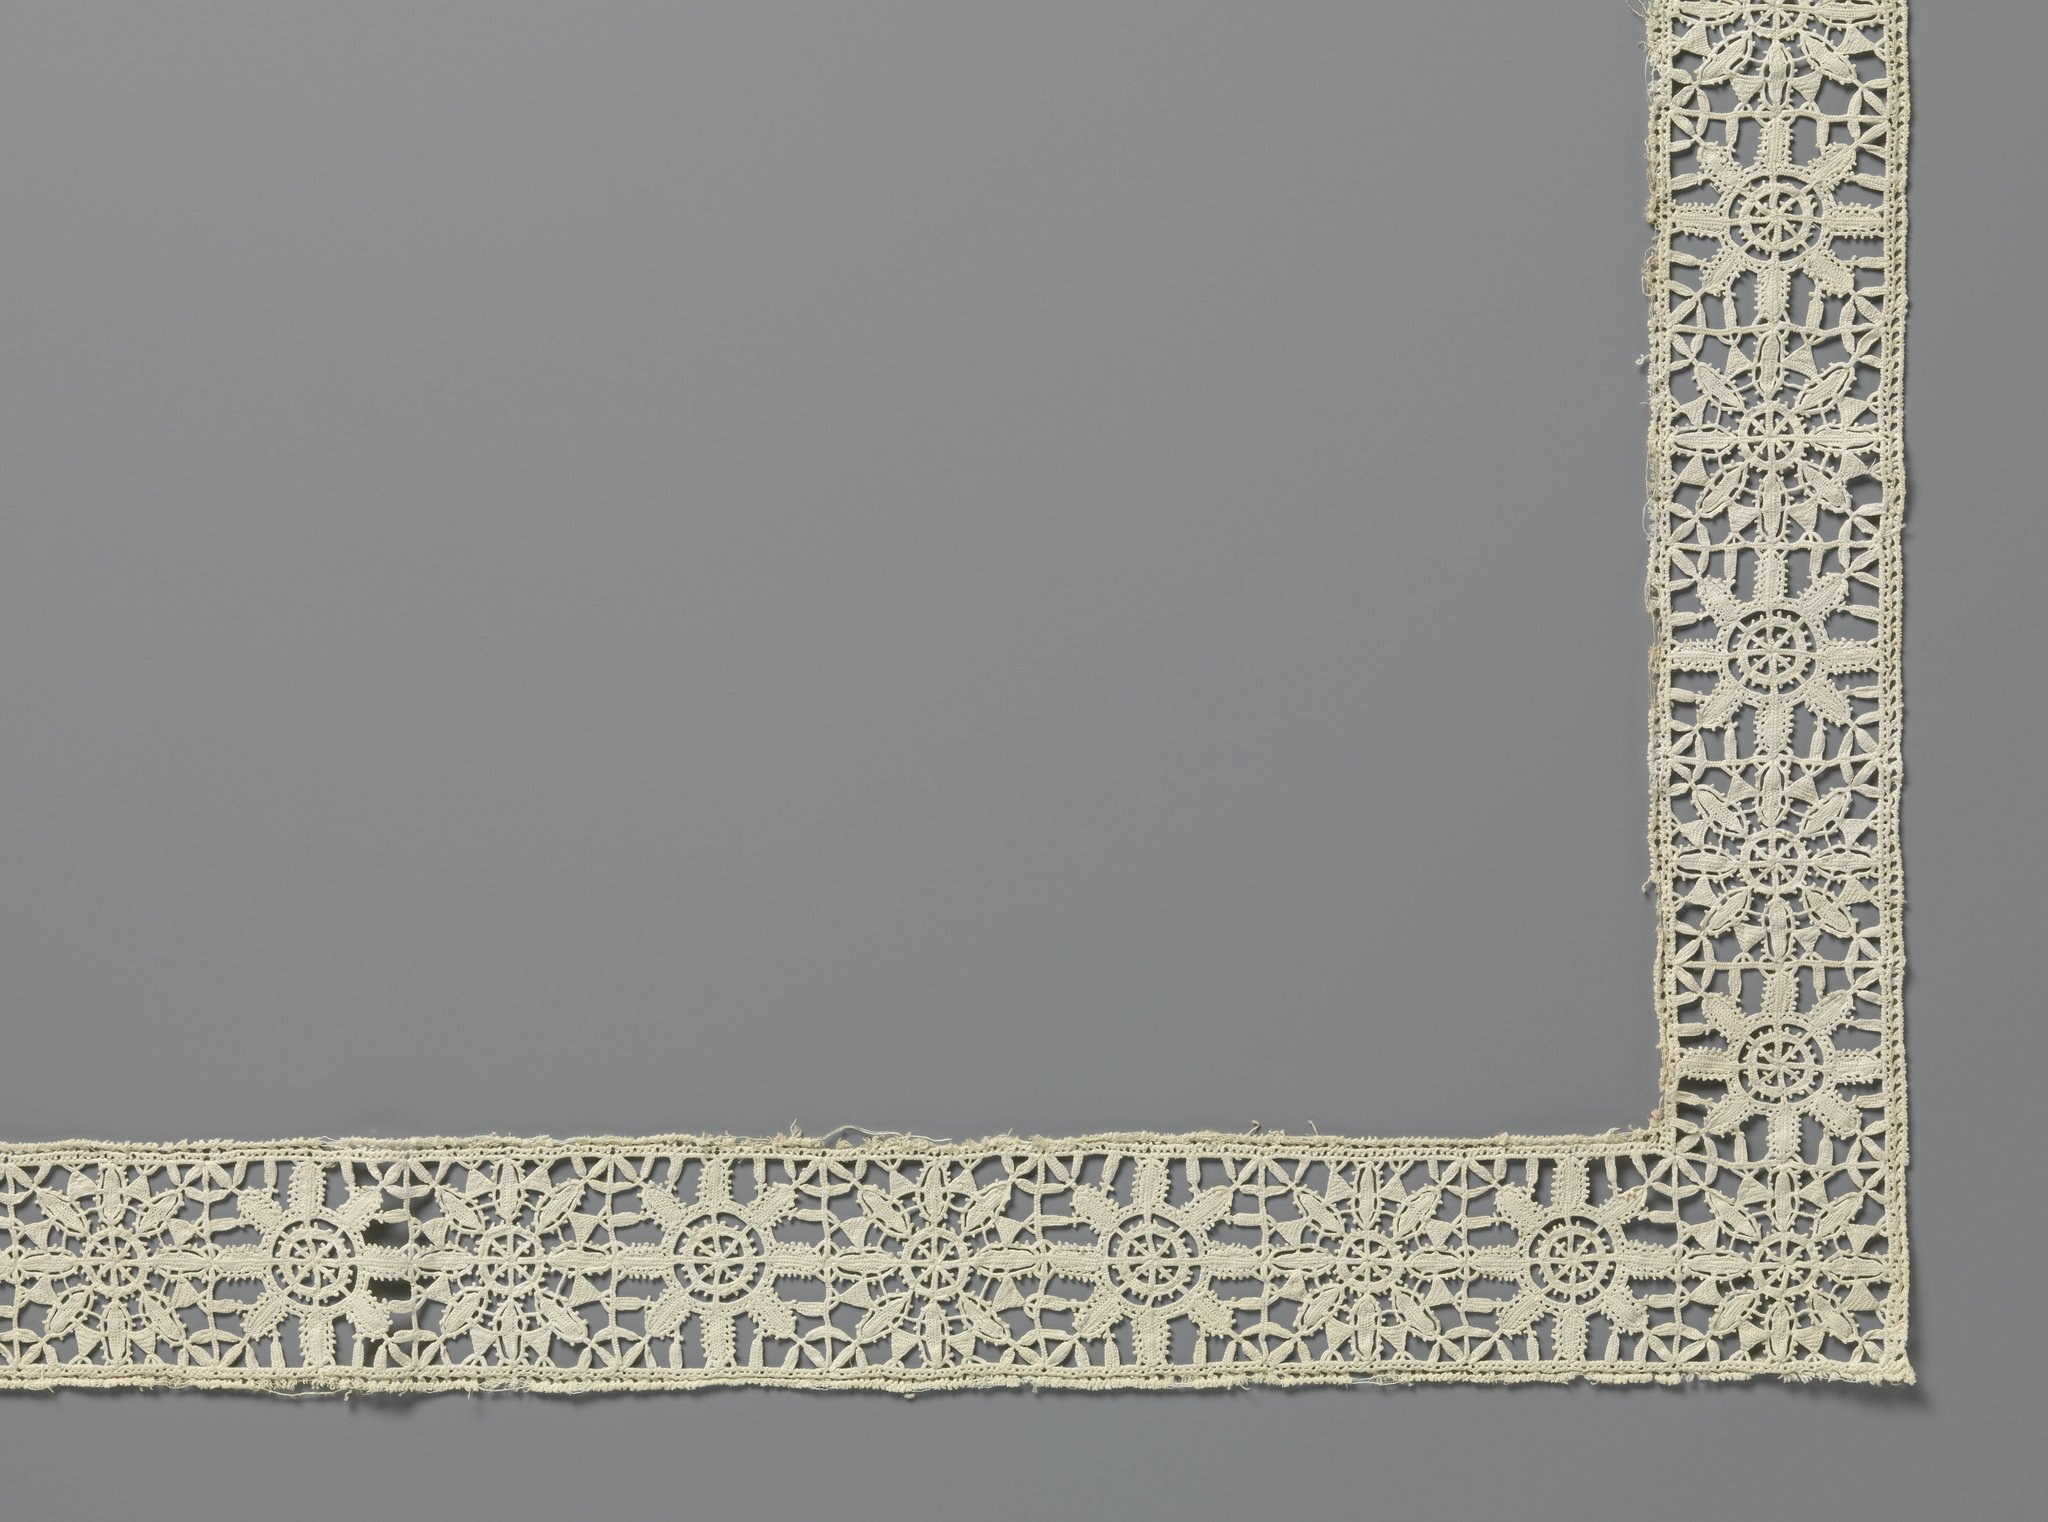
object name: entre deux, tussenzetsel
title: Tussenzetsel van naaldkant met rozetten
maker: Anonymous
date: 1590-1599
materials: linen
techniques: needle lace, reticella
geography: italy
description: Langgerekt u-vormig tussenzetsel van naaldkant, reticella of gesneden werk. Mogelijk afkomstig van een beddenlaken. Het rasterwerk van het patroon bestaat uit één rij grote vierkanten, die per vierkant zijn opgebouwd uit vier kleine vierkanten. In de grote vierkanten zijn afwisselend twee soorten rozetten gemaakt. De ene met acht gepicoteerde punten en de andere met acht spitsovale punten die met driehoekjes aan elkaar zijn verbonden. Gewerkt op tweezijdig uitgehaald linnen, grond met zowel gefestoneerde als omwoelde spijlen, deels gepicoteerd. Volwerk met knoopsgatensteken, zonder siersteken. Boven- en onderzijde van de strook zijn afgewerkt met een dubbele rechte rand.